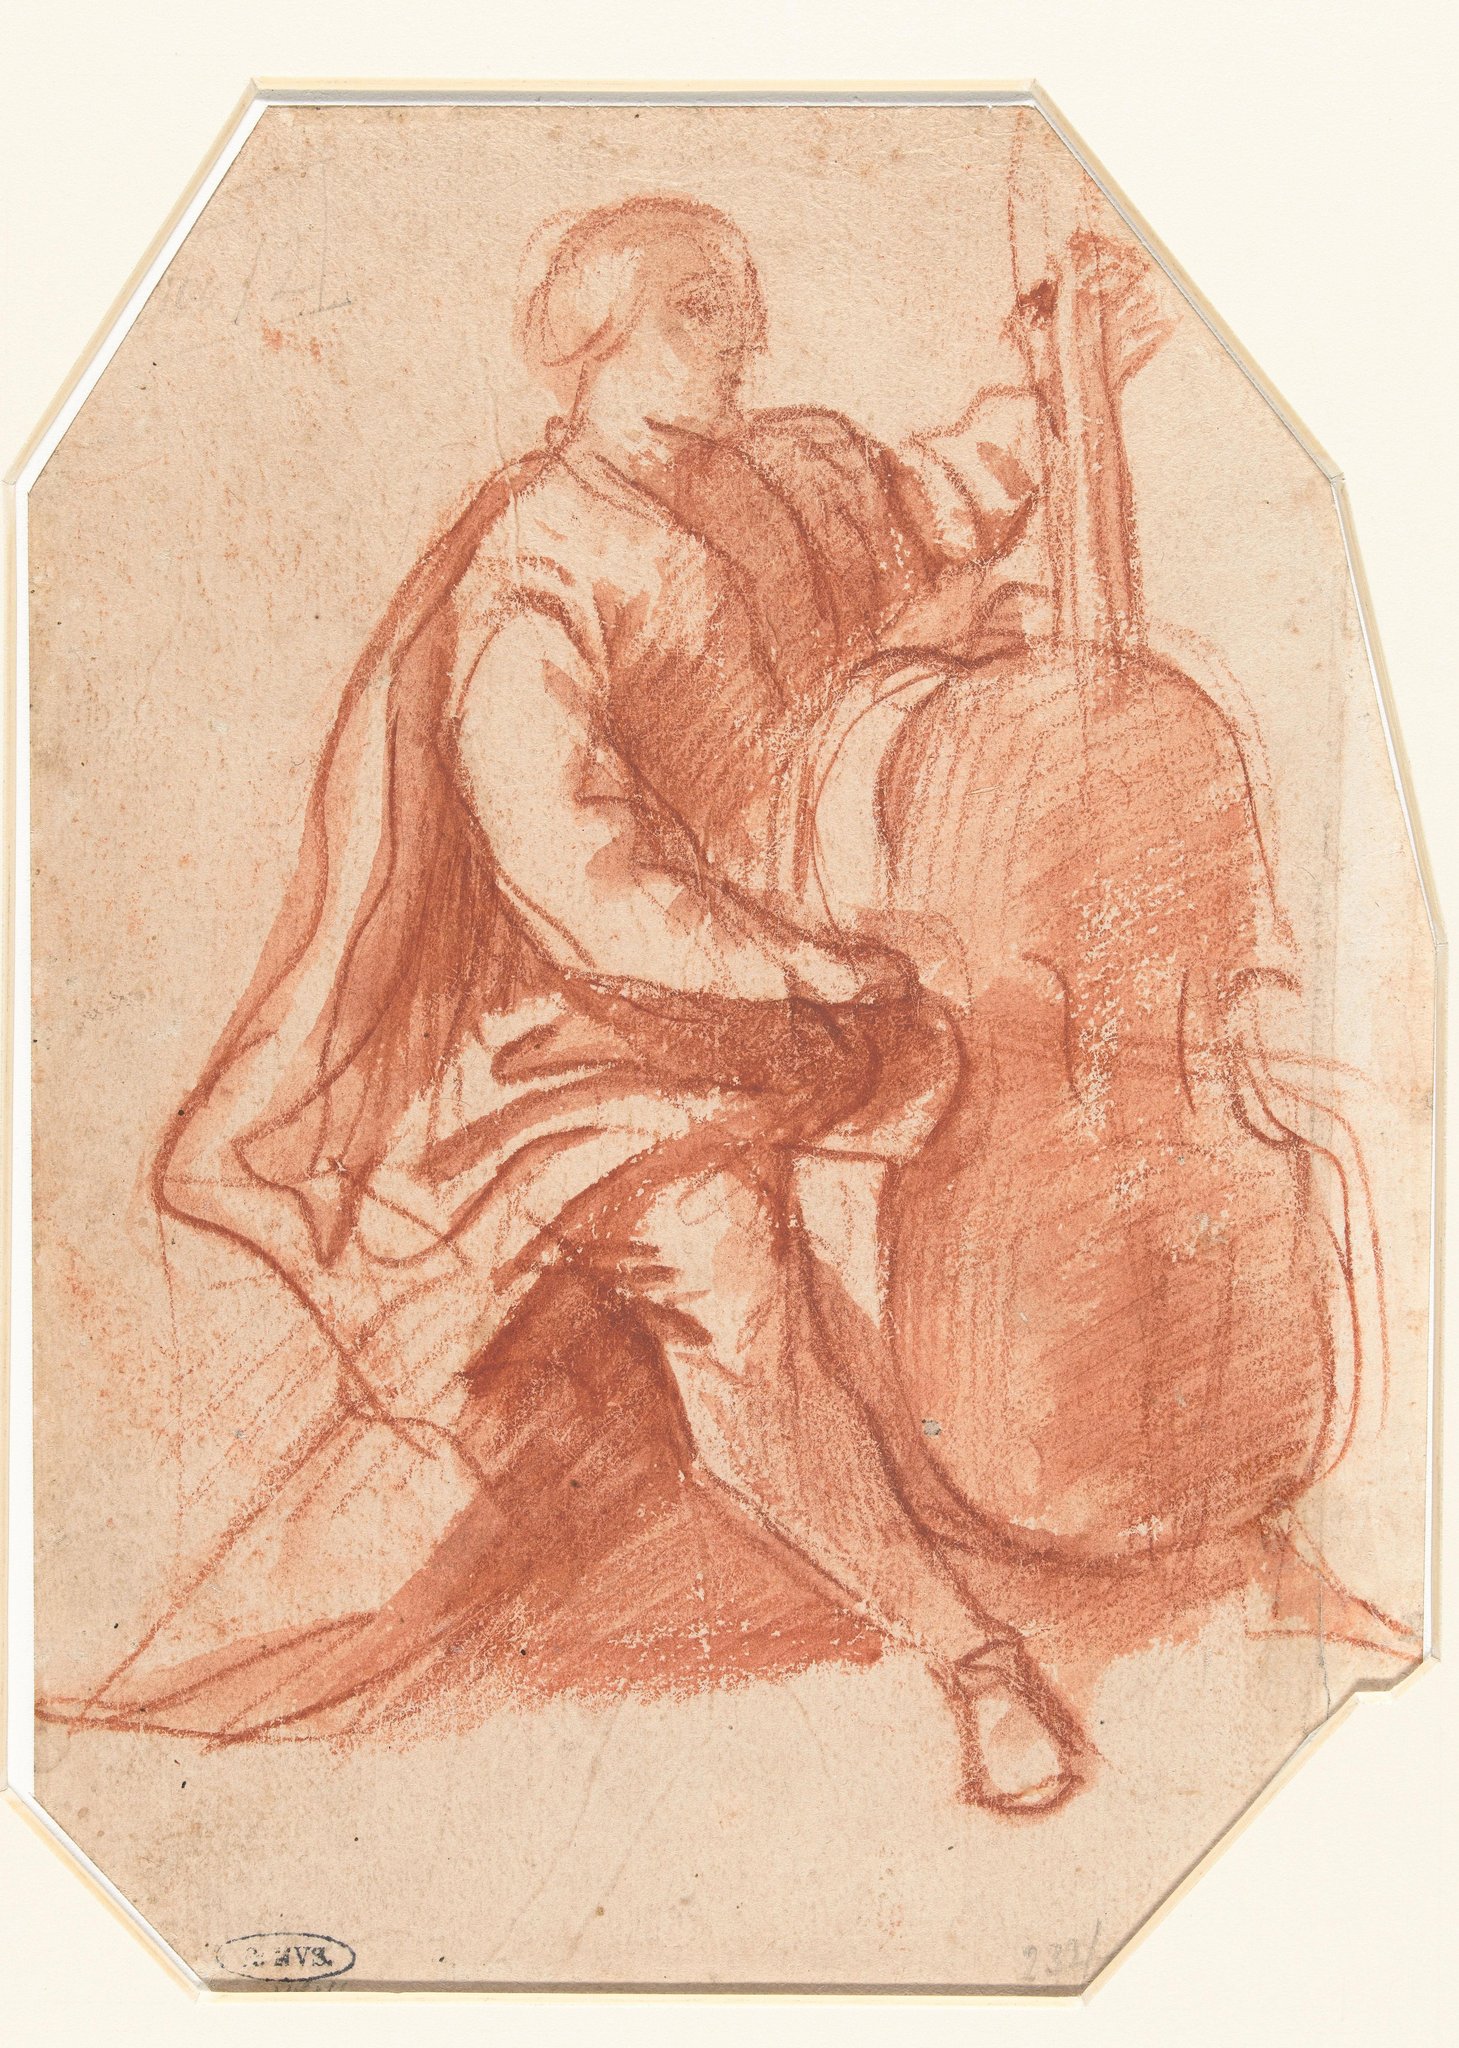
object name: drawing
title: Viola da gambaspeler, driekwart van opzij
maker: pier francesco mola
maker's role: draughtsman, print maker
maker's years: 1612-1666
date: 1645-1650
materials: chalk, paper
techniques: brush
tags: one person playing string instrument (bowed), viola, violoncello; double bass